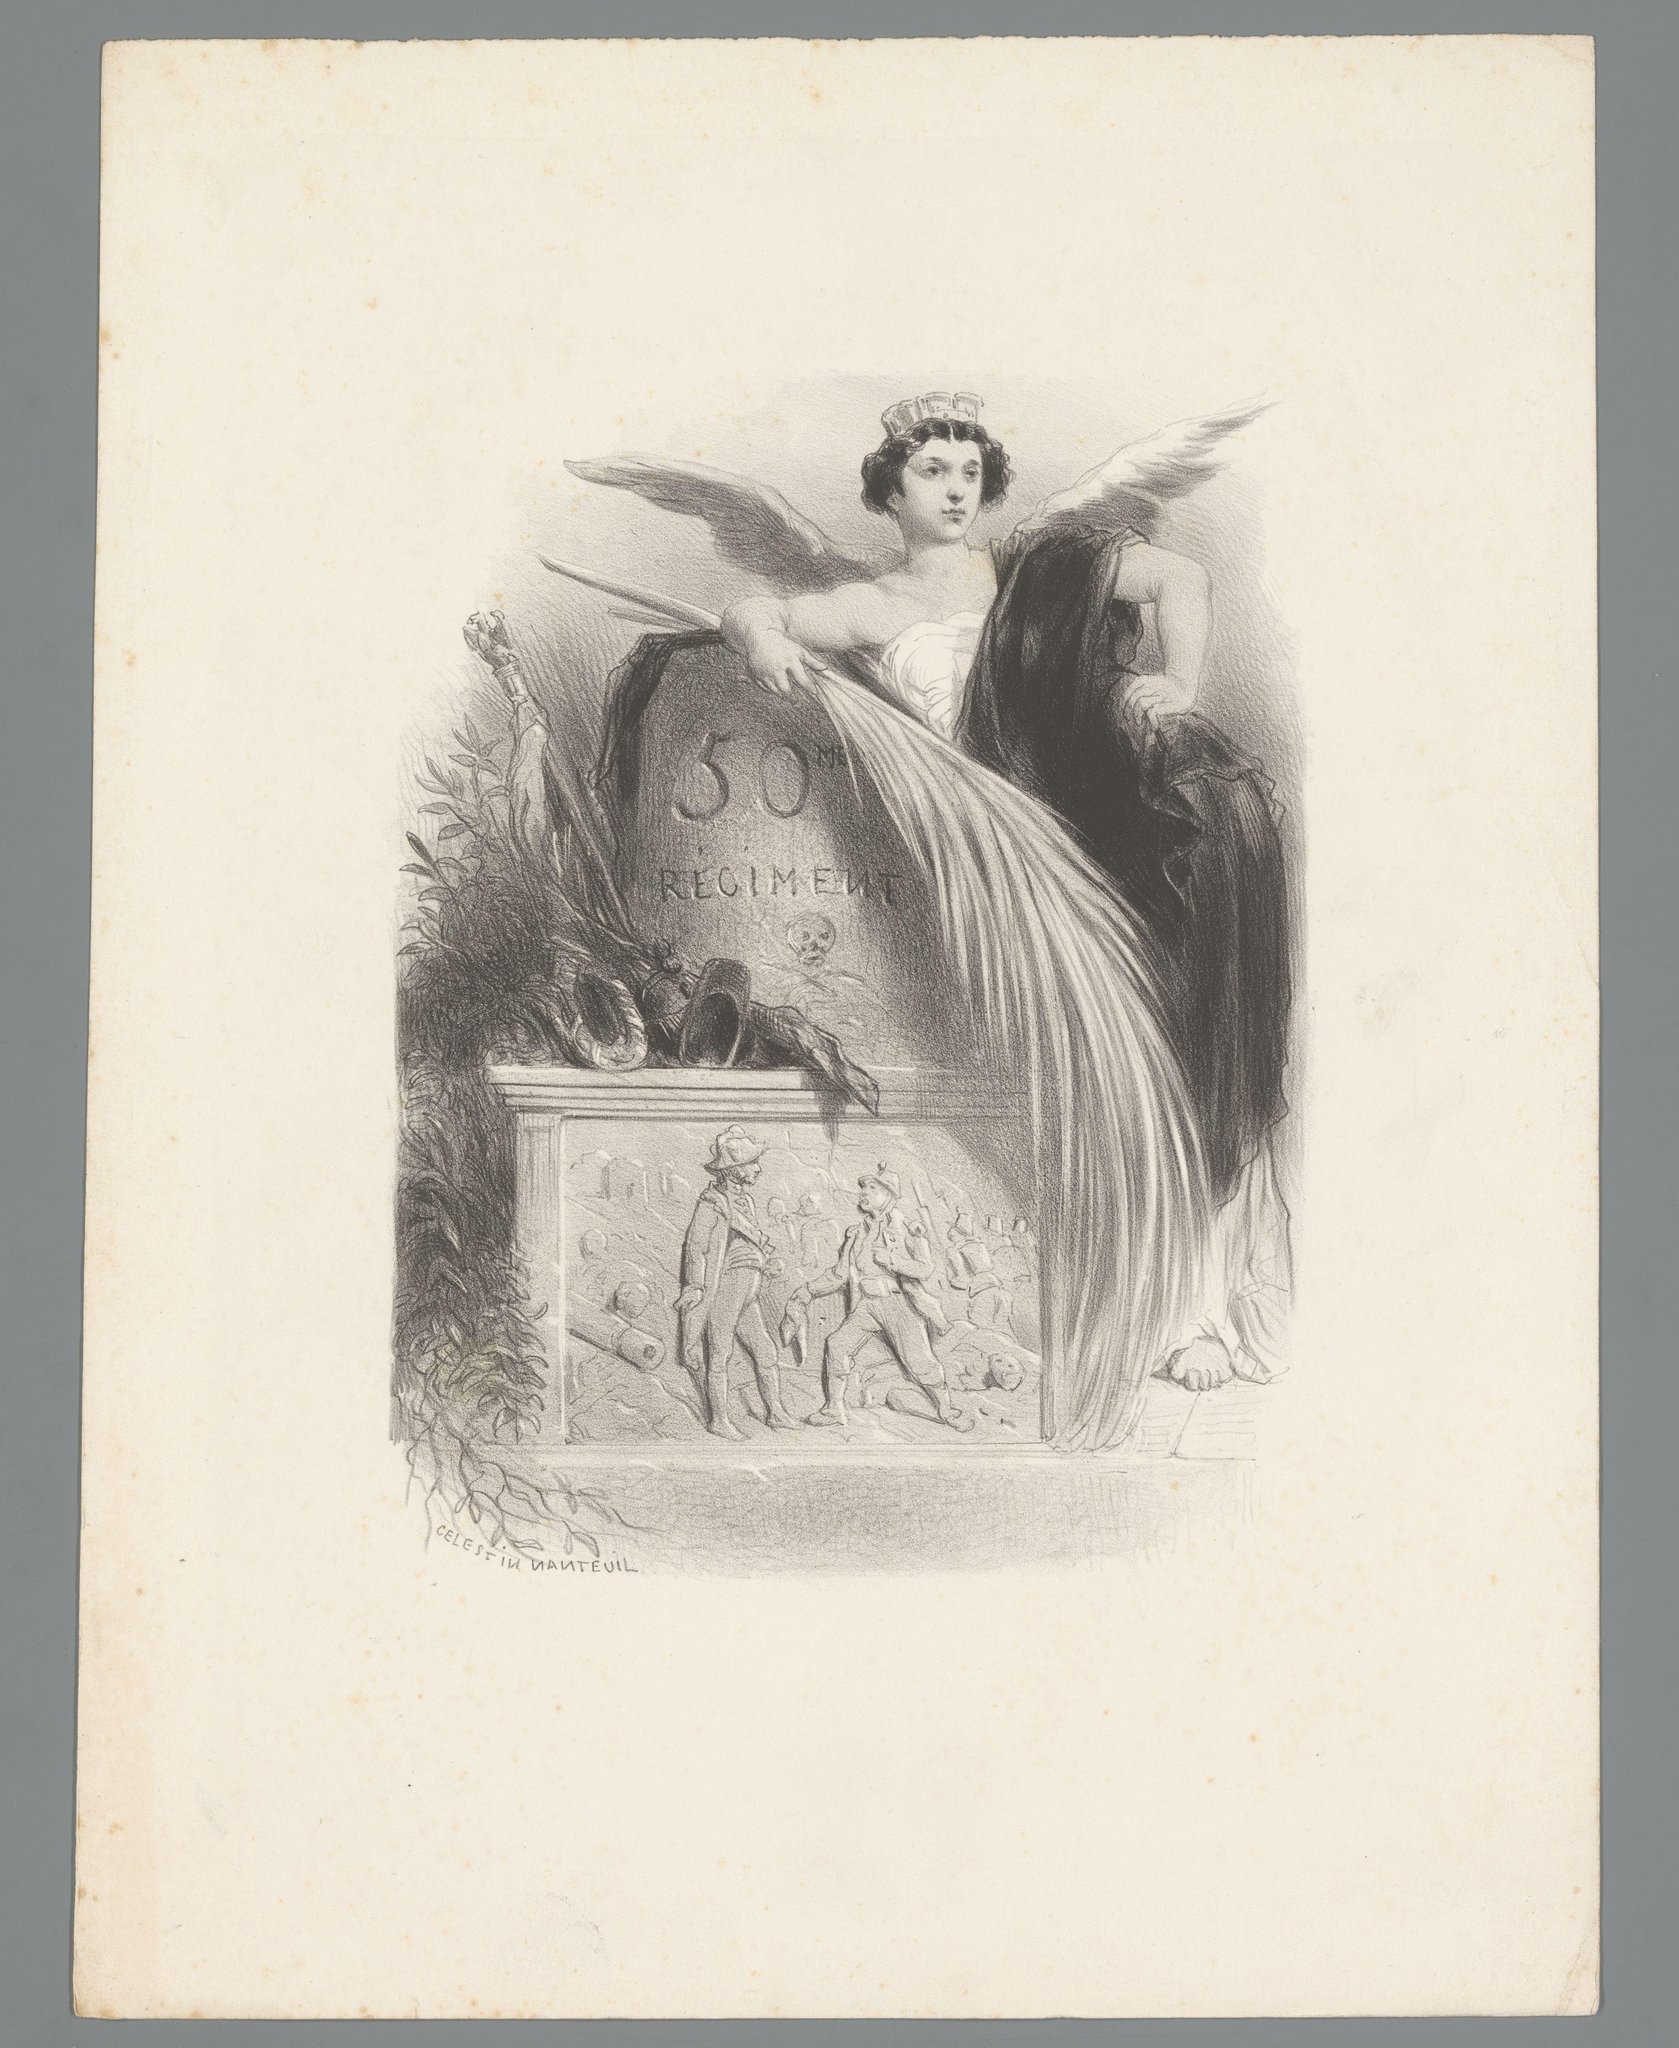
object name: print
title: Engel met stedenkroon en palmtak staand naast een monument voor het 50ste regiment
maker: célestin françois nanteuil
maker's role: print maker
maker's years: 1813-1873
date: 1823-1873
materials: paper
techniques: lithograph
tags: city-crown, mural crown, angels crowning and/or bringing palm-branches, garland, wreath, sceptre, staff (symbol of sovereignty), monument, statue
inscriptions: collector's mark: Lugt 964